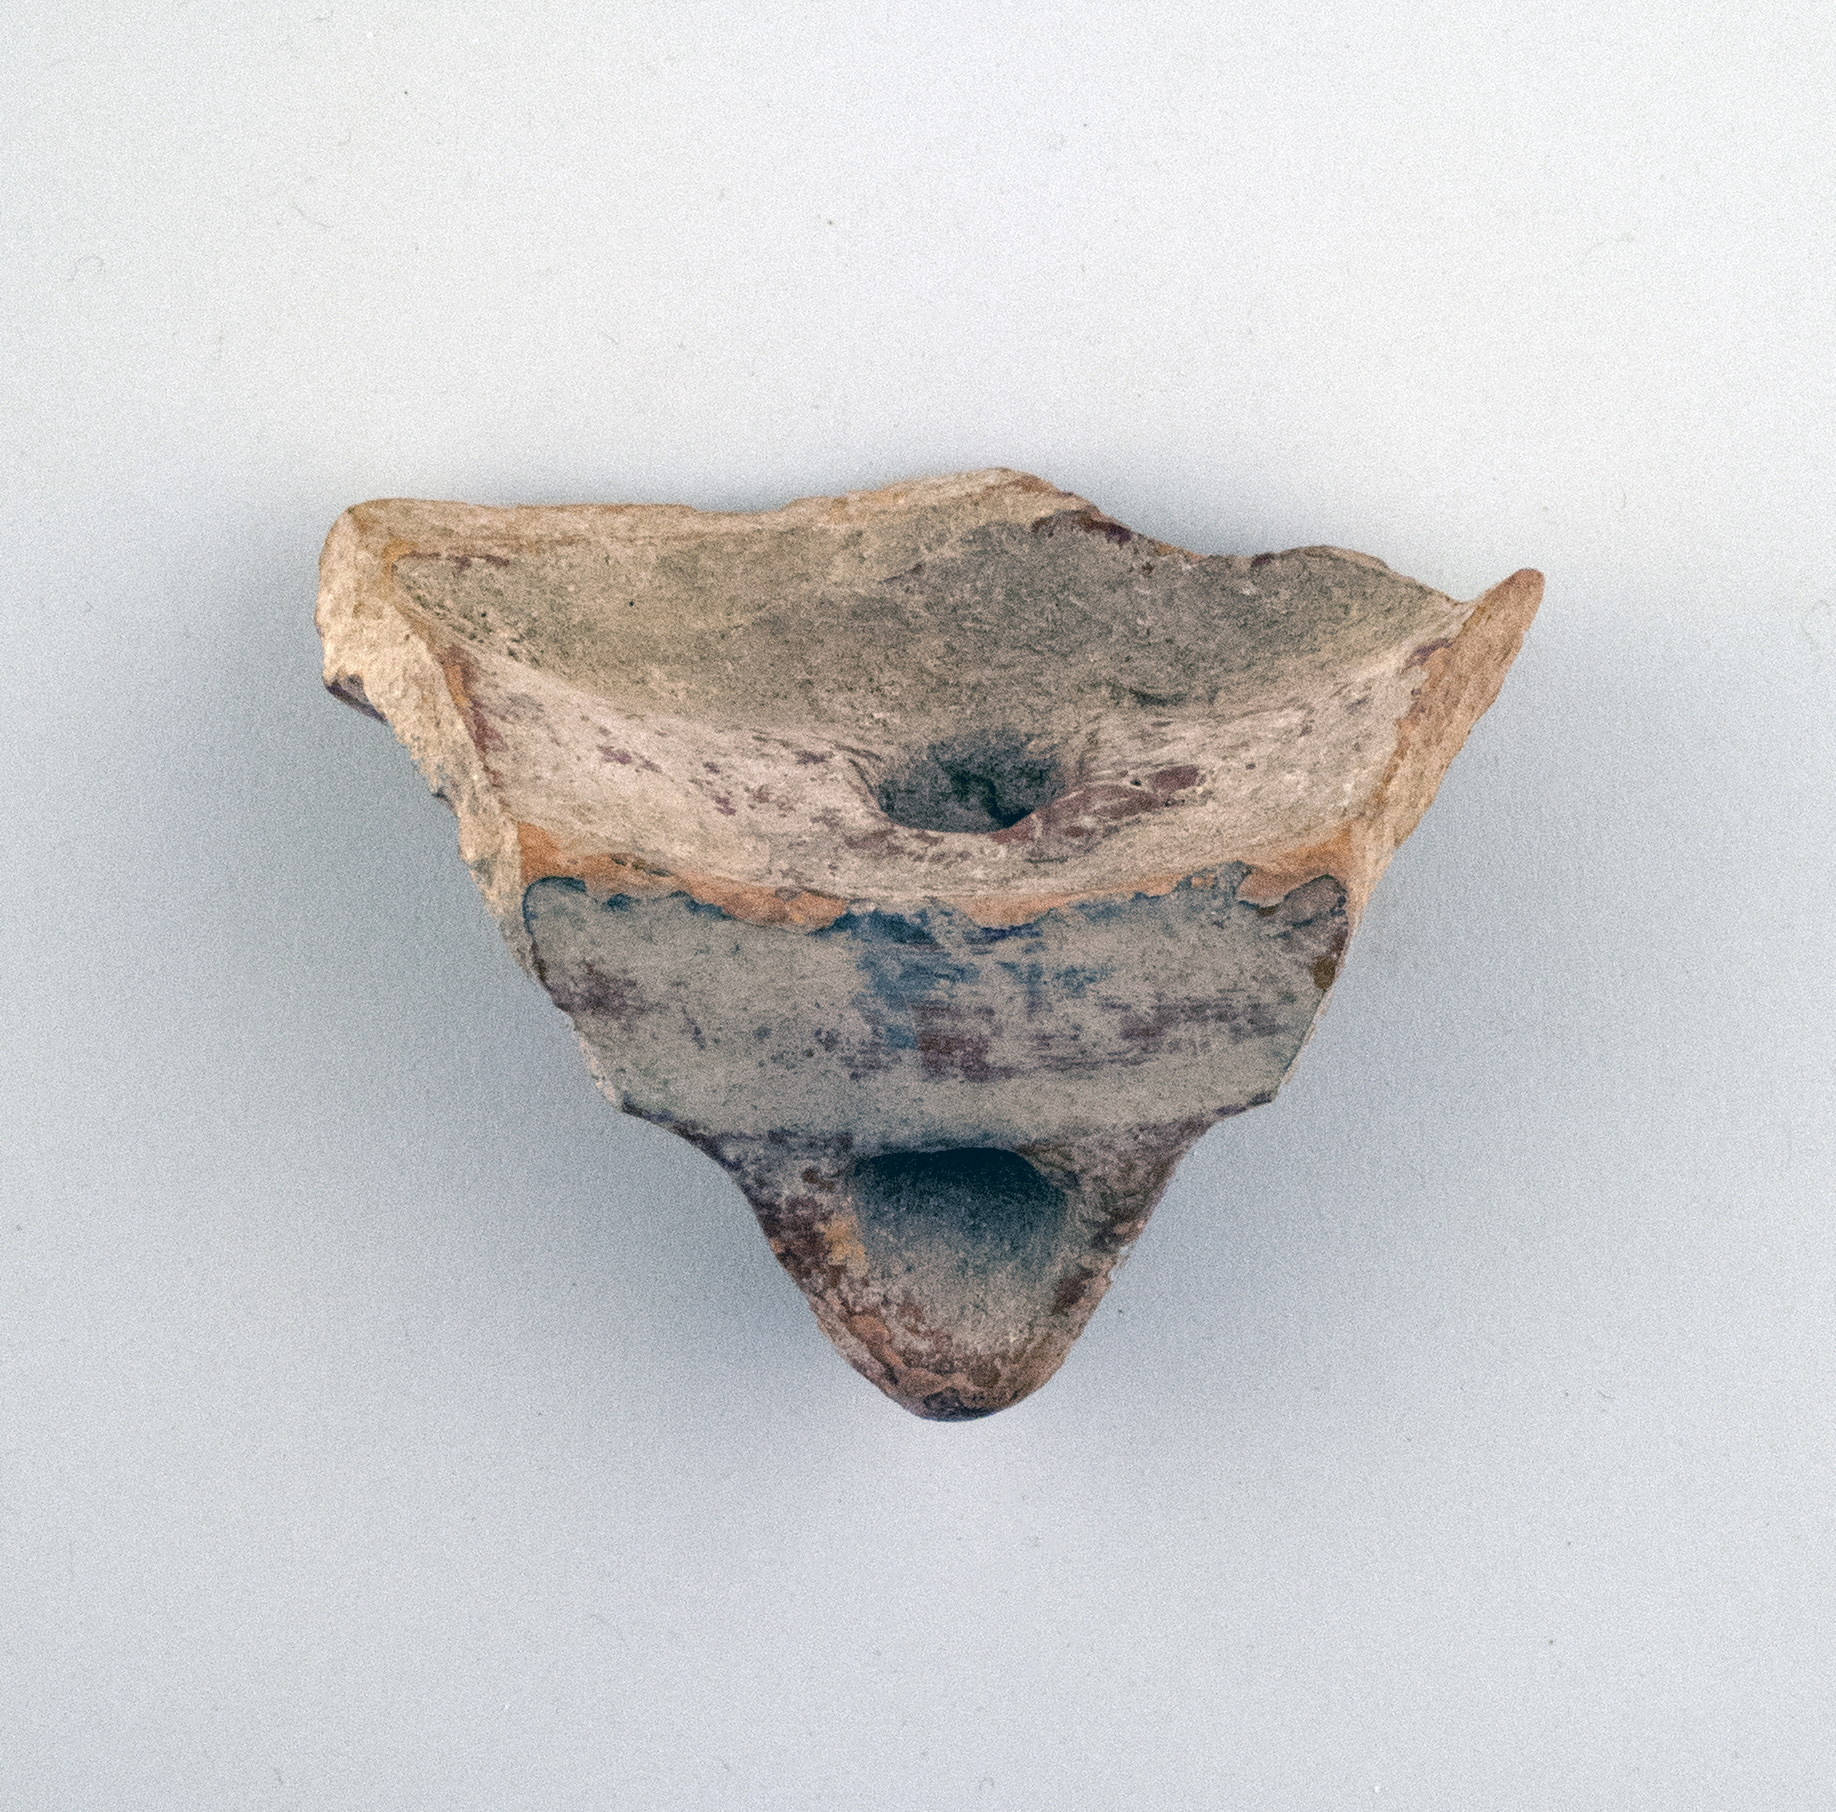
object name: lamp nozzle and rim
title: Terracotta lamp nozzle and rim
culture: greek or lydian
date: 900-30 BCE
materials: terracotta